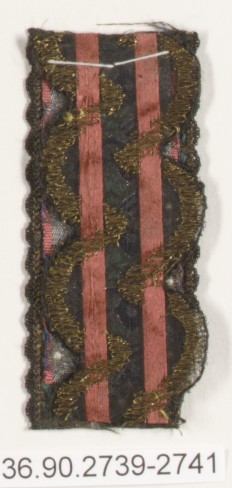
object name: ribbon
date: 1801-1900